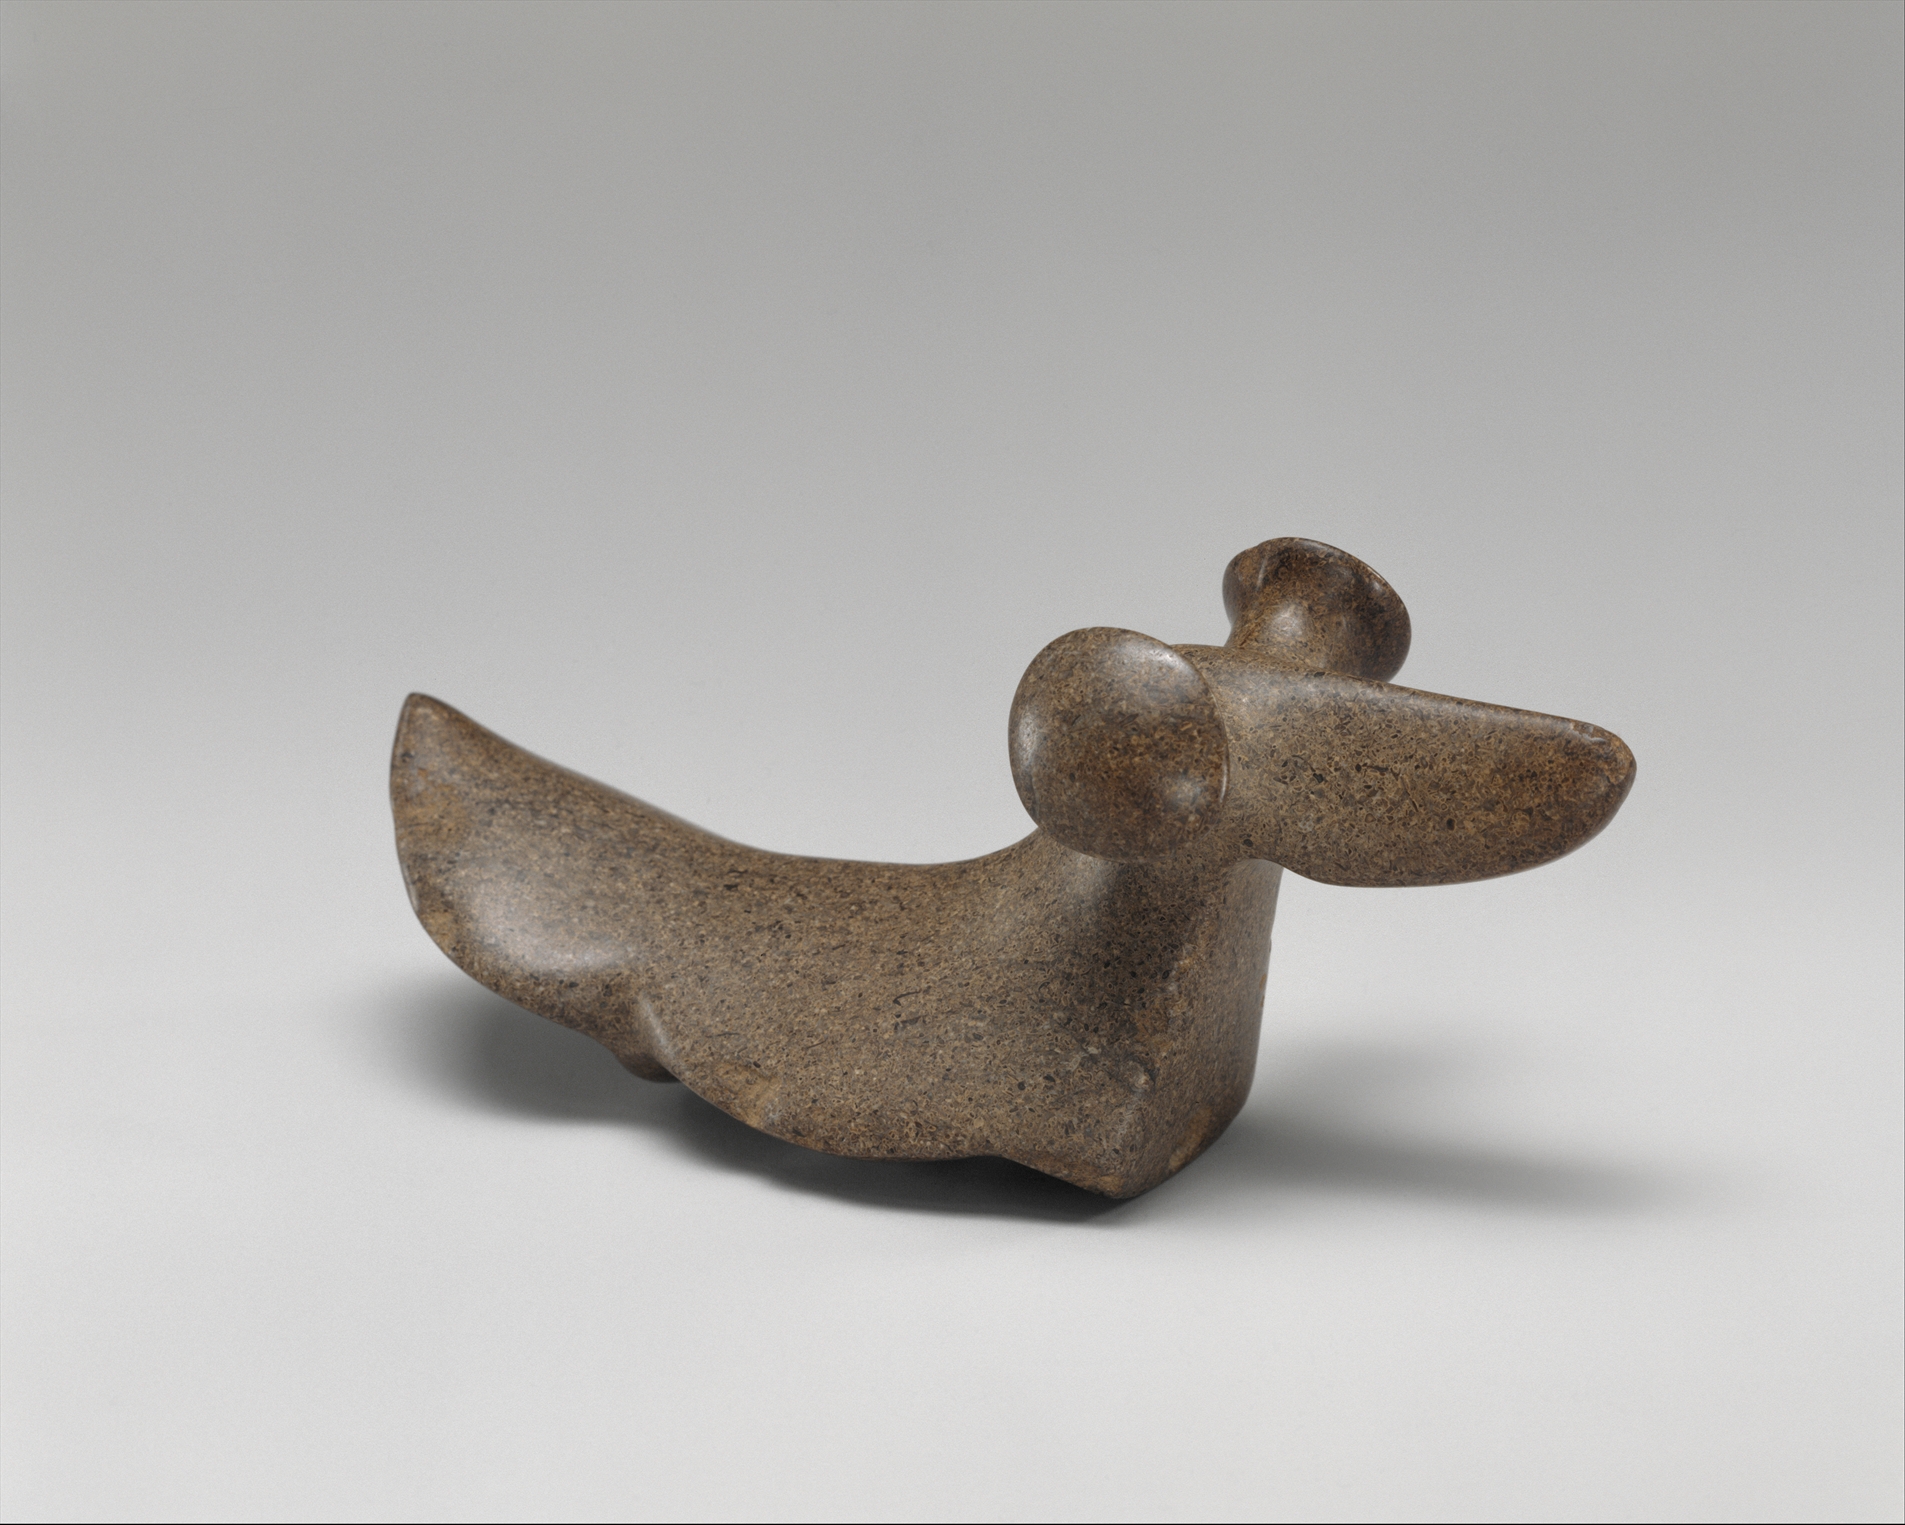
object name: birdstone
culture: archaic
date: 1500-500 BCE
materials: limestone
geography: united states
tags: birds